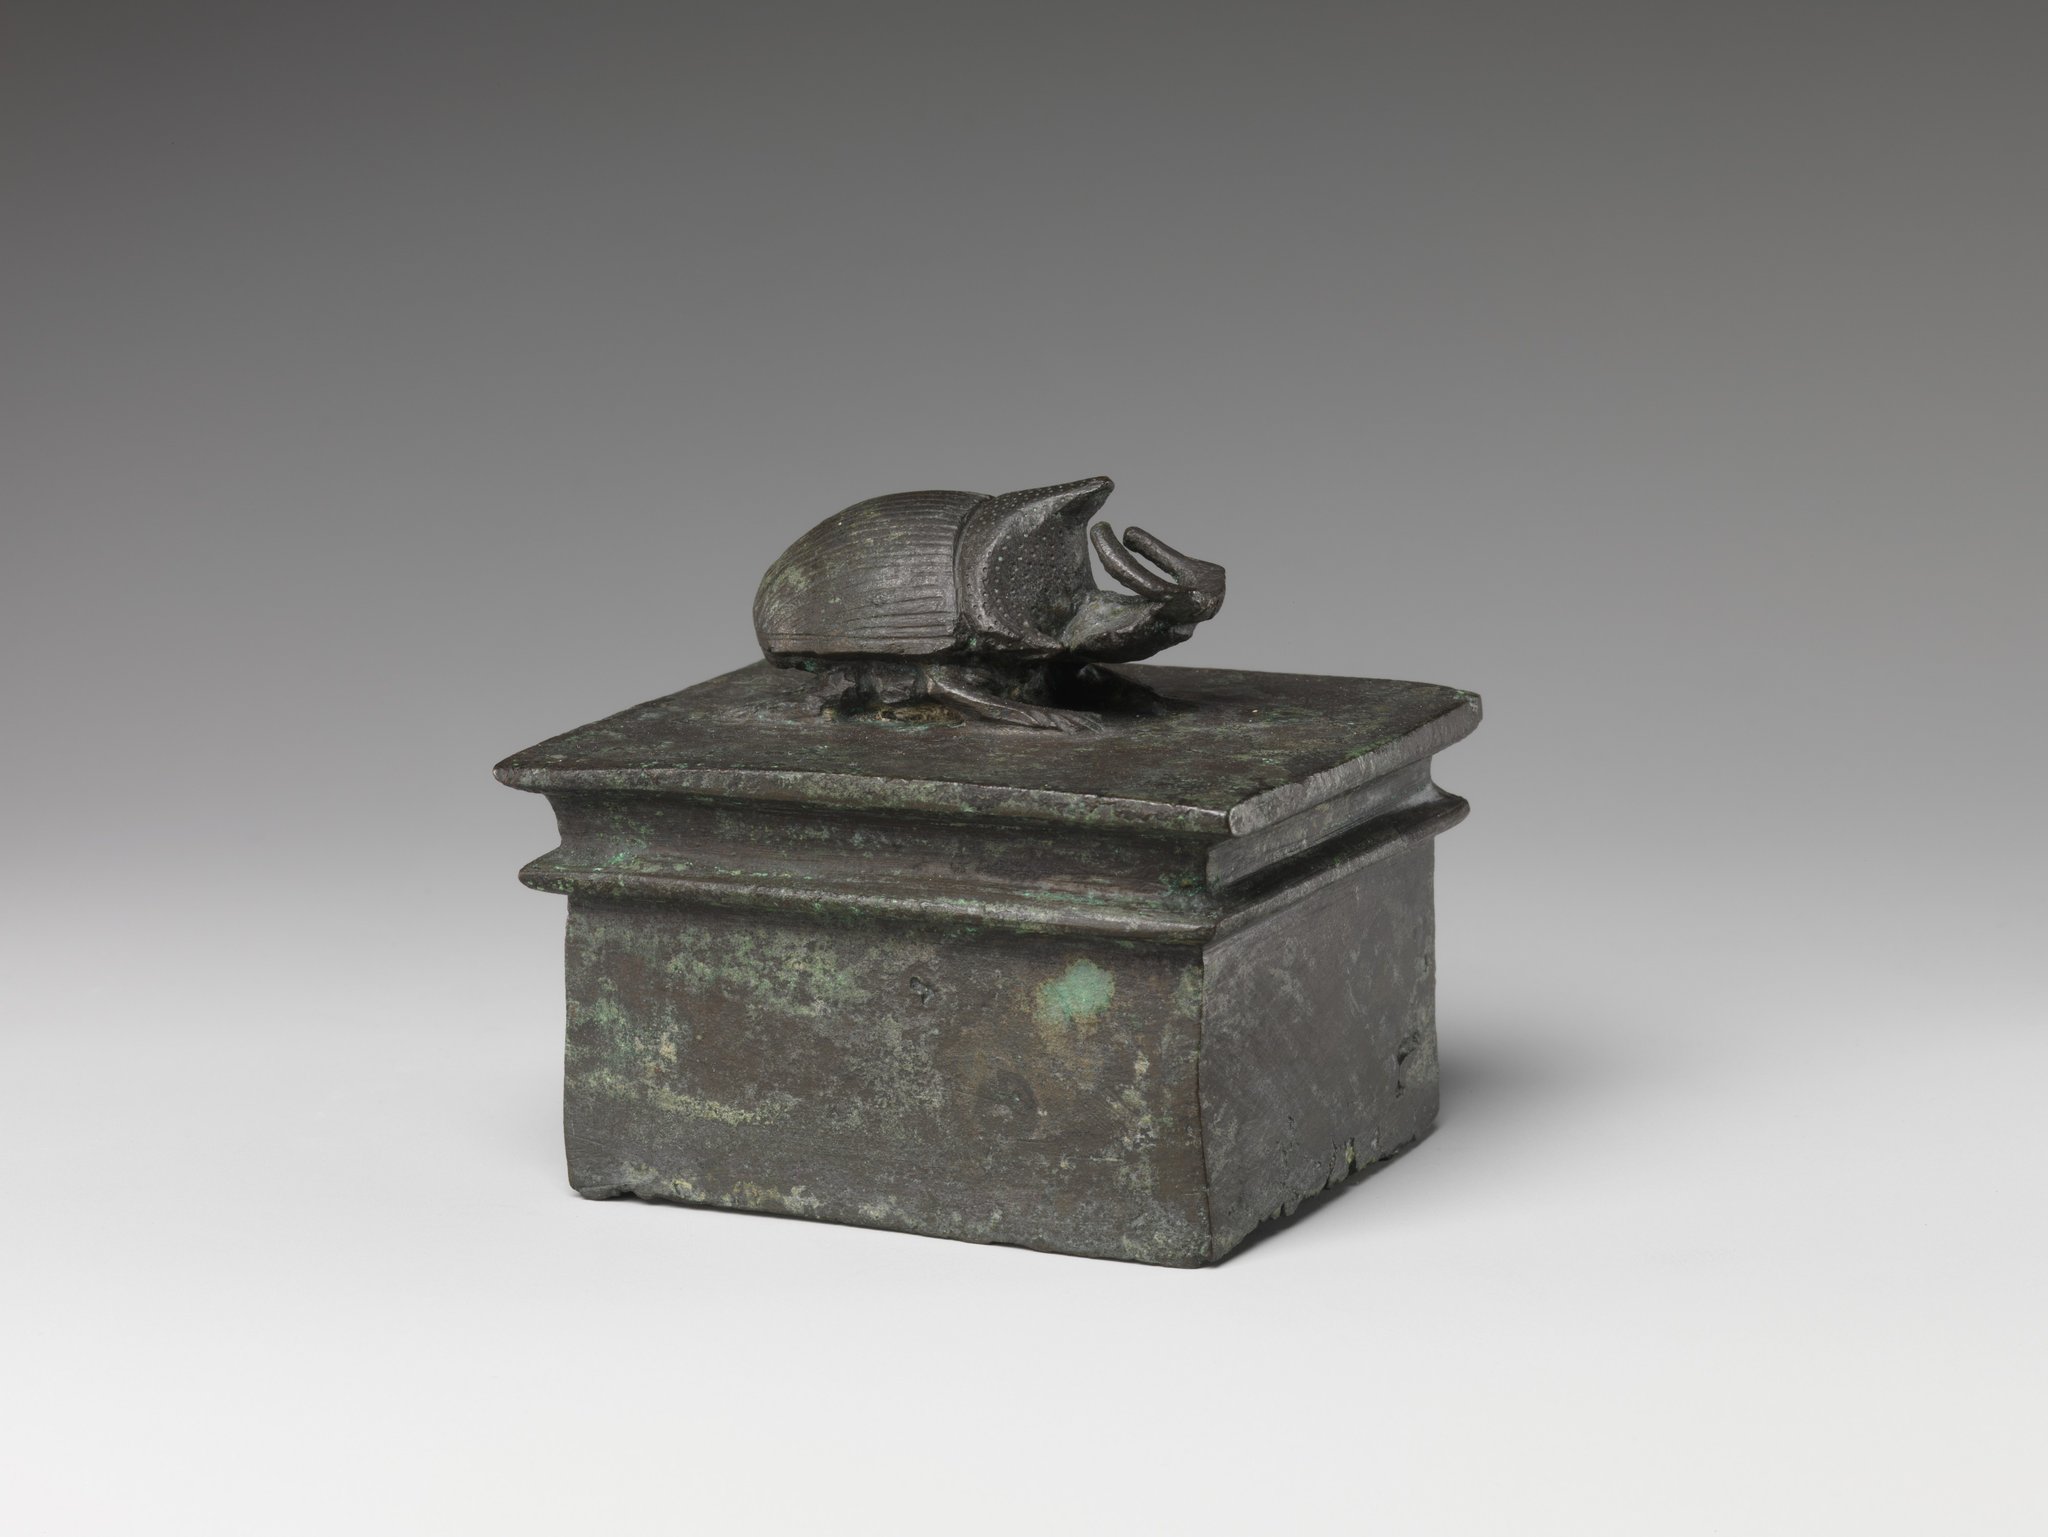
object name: box, rhinoceros beetle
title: Rhinoceros beetle box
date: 664-630 BCE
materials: metal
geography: egypt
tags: insects